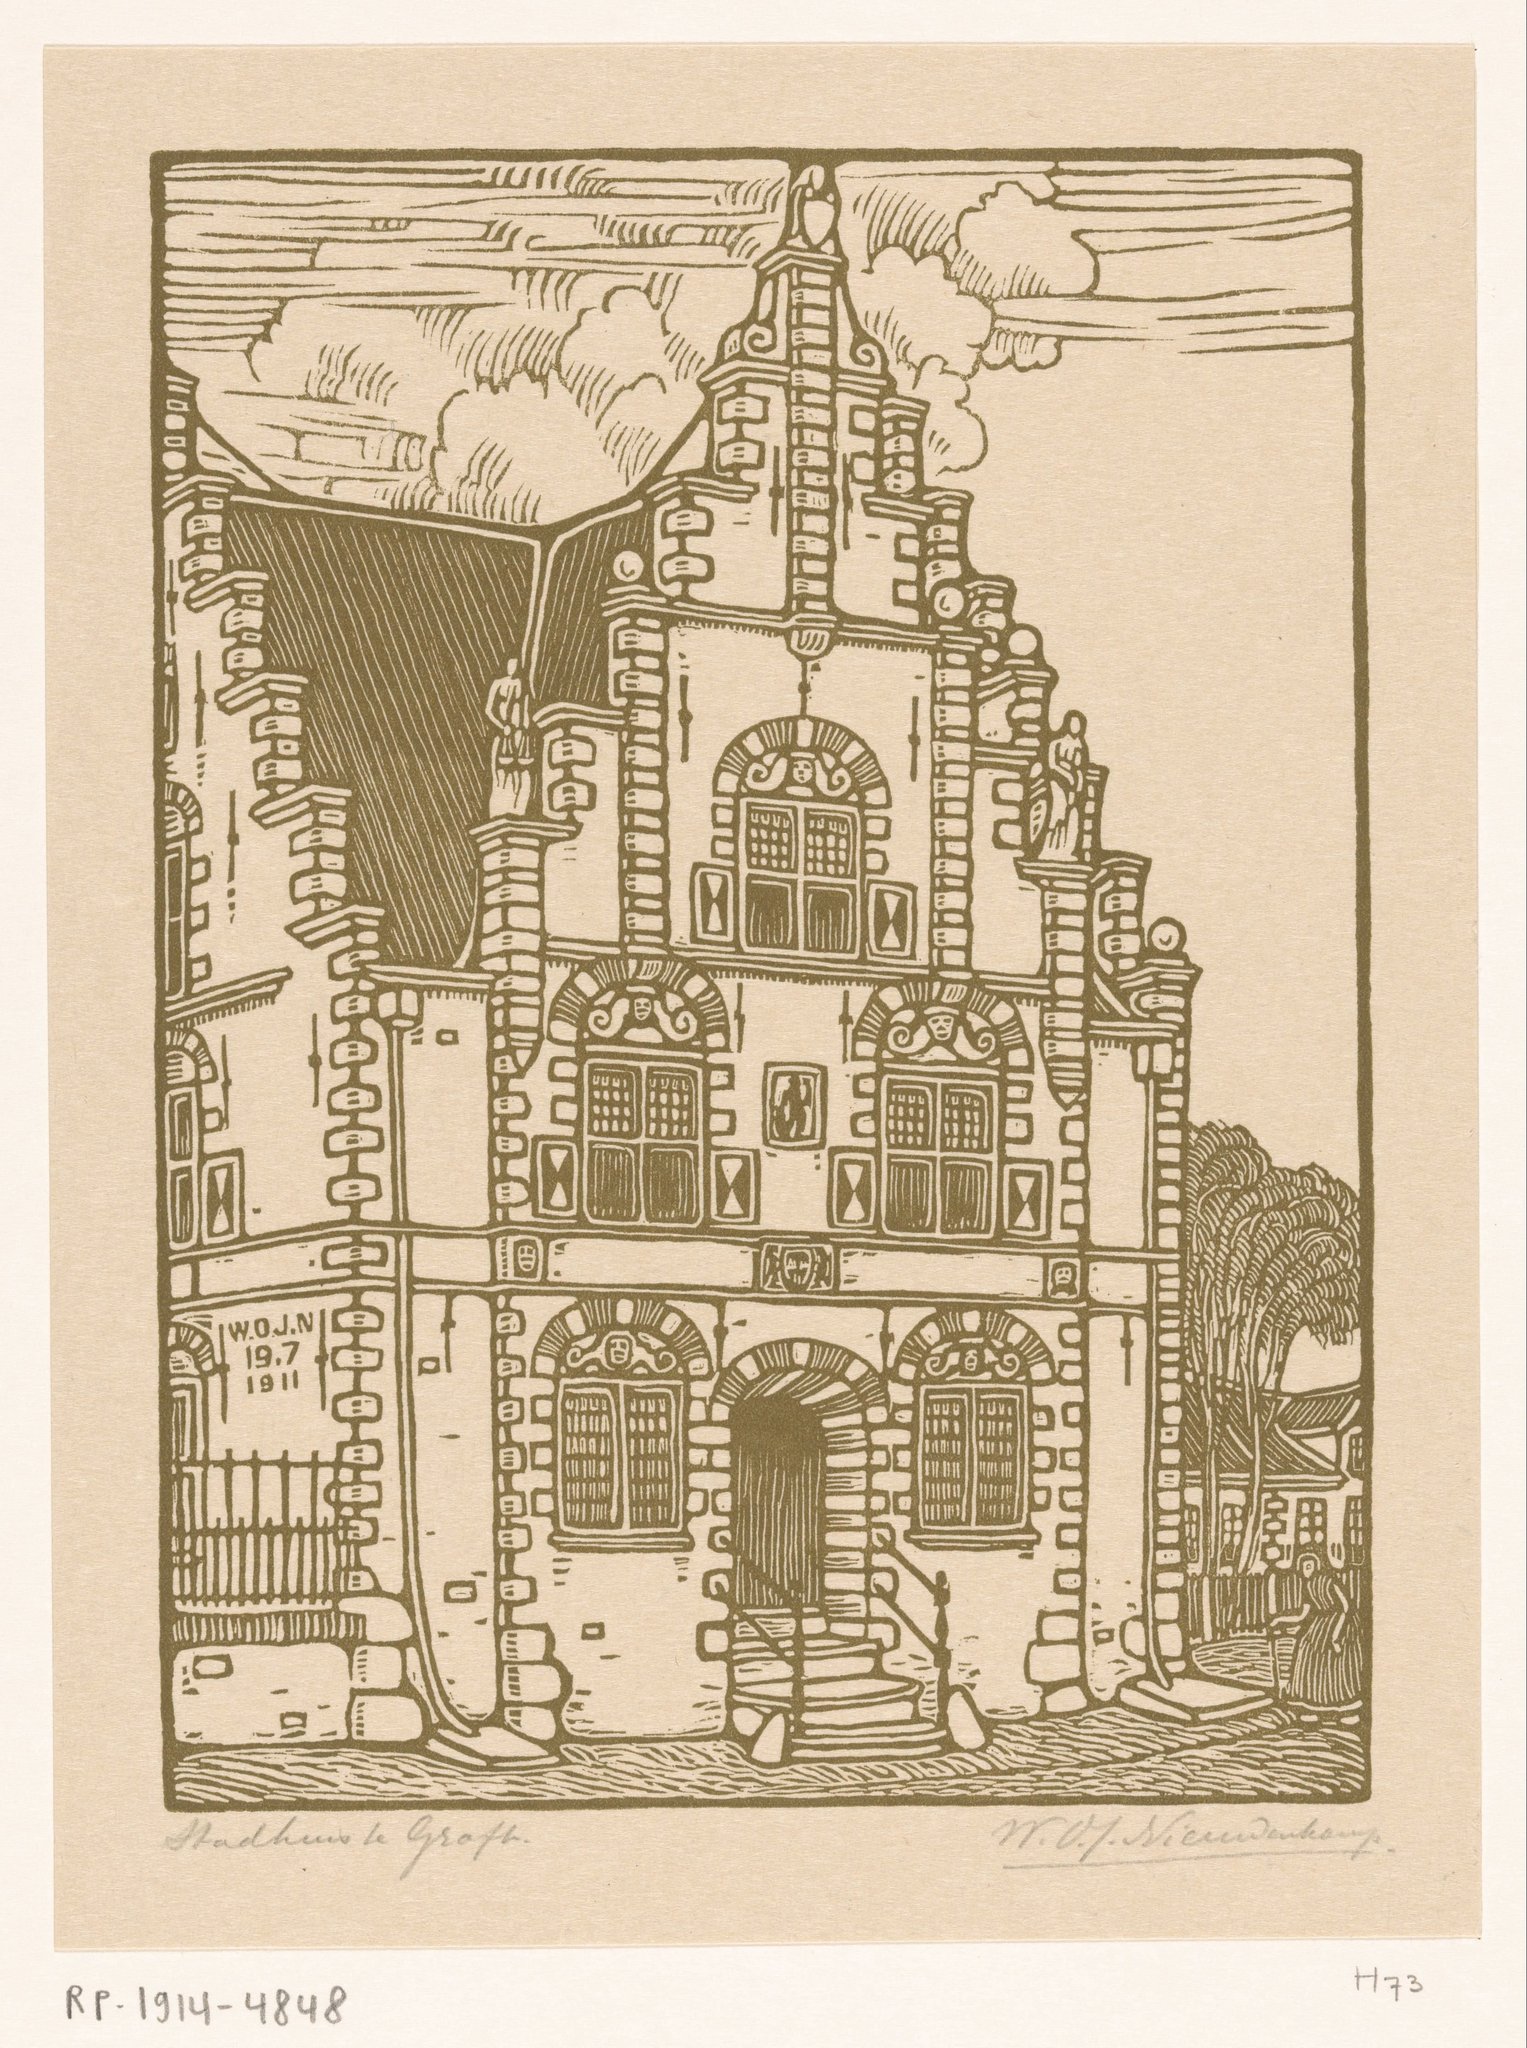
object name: print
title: Stadhuis te Graft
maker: wijnand otto jan nieuwenkamp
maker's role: draughtsman, print maker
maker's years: 1874-1950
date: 1907-1911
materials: paper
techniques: woodcut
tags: townhall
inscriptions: collector's mark: Lugt 2233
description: De voor- en zijgevel van het stadhuis in het dorp Graft in de gemeente Alkmaar. Rechts op de achtergrond nog een gebouw.